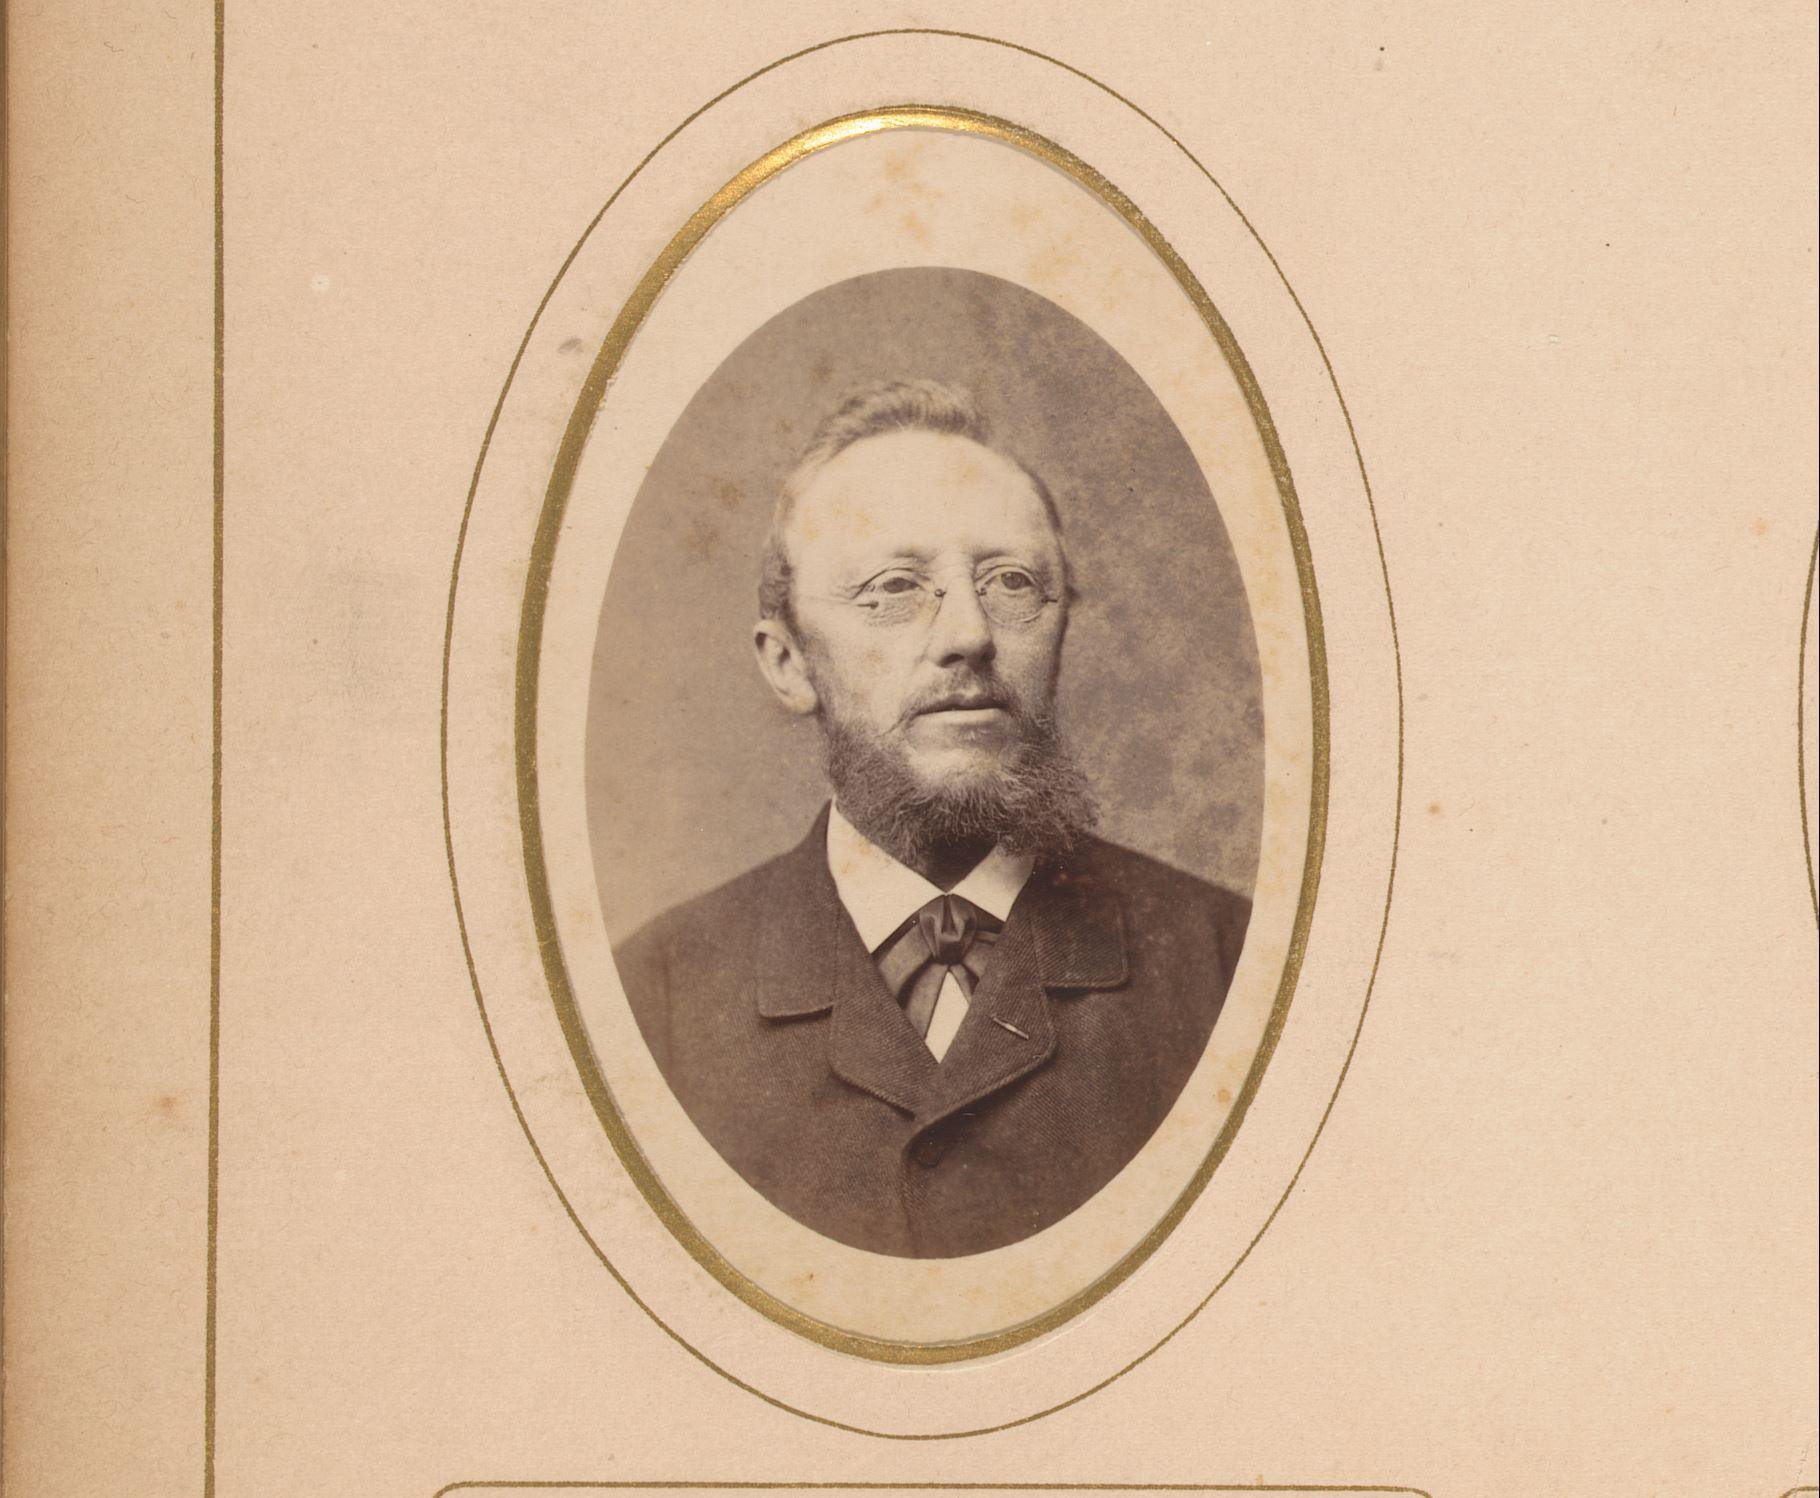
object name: album leaf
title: Portret van een man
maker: johannes wilhelmus franciscus offenberg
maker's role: fotograaf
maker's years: 1839-1919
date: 1867-1888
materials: cardboard, photographic support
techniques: albumen print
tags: historical persons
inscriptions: inscription: ‘OFFENBERG/ PHOTOGRAPHE/ DE S.M. LA REINE DES PAYS BAS/ DAMSTRAAT/ Amsterdam’